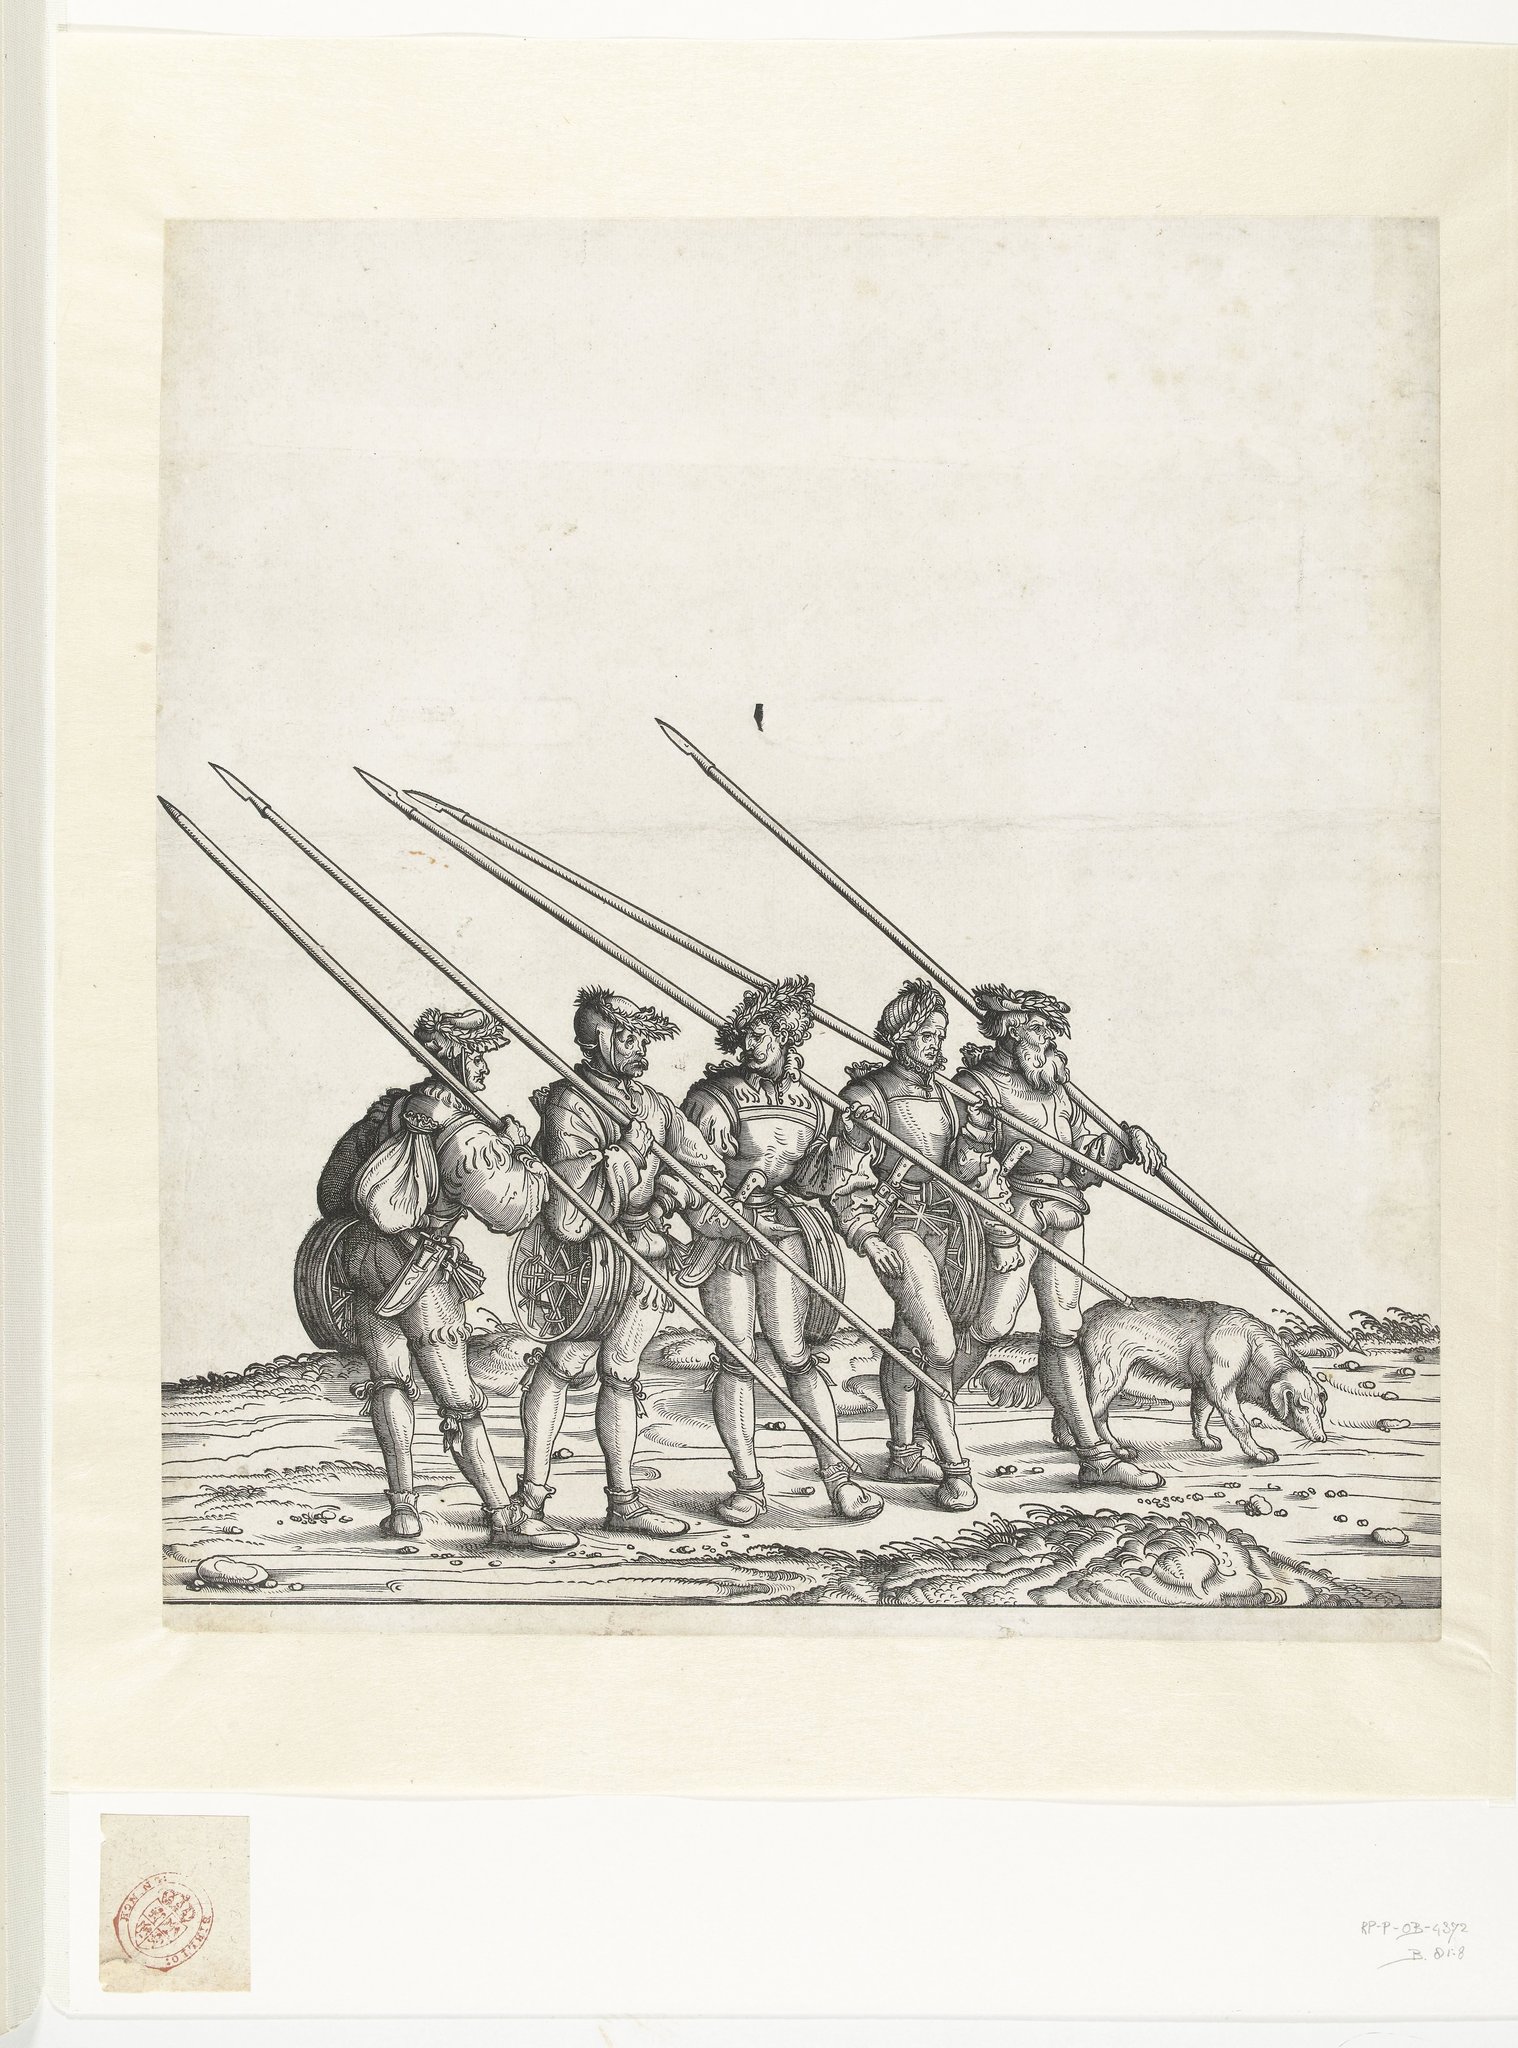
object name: print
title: Triomf van Keizer Maximiliaan I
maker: hans burgkmair (i)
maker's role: draughtsman, print maker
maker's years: 1473-1531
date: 1483-1526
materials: paper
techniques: woodcut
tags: hunter, symbolic triumphs of individual persons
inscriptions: collector's mark: Lugt 240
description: Houtblok gebruikt voor: Marx Treitzsaurwein, Triomf van Keizer Maximiliaan I, 1526. Volgens Biedermann zijn de prenten uit de triomf in de collectie van het RMA proefdrukken waarbij de tekstbanden werden afgedekt voor de druk (Biedermann 1973, niet gepagineerd). Boven de vijf jagers zijn twee kleine vlakken zichtbaar die afgedekt werden. De literatuur noemt echter geen variant met tekst.